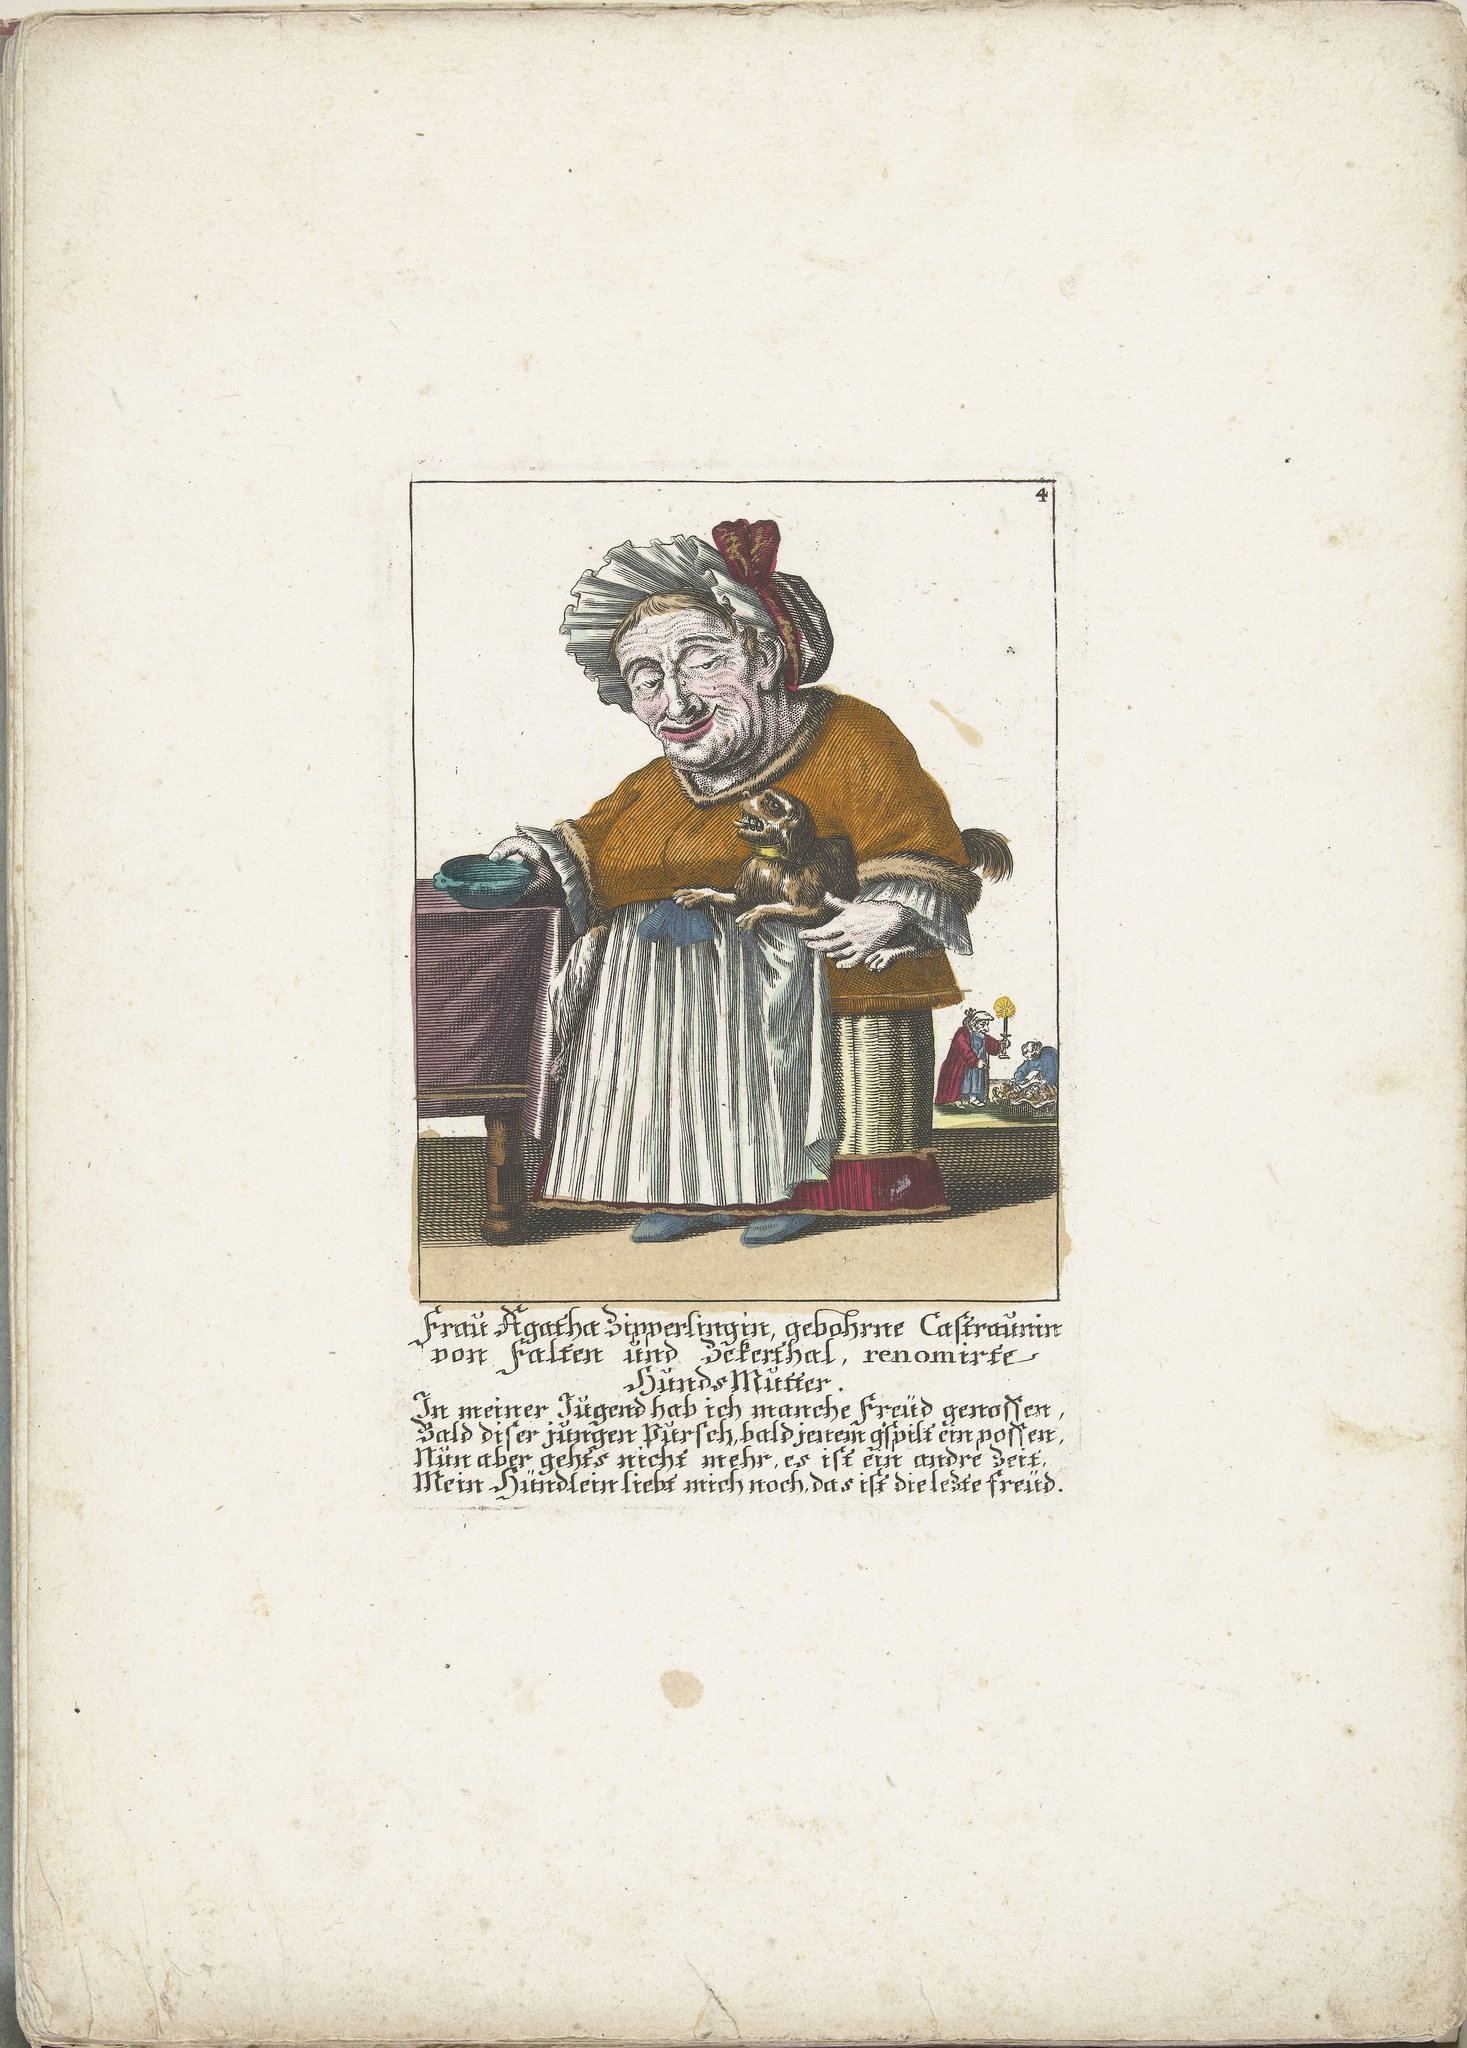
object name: caricature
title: Frau Agatha Zipperlingin, gebohrene Castaunin von Falten und Zeckerthal, renomirte Hundsmutter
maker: martin engelbrecht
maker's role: print maker, publisher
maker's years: 1684-1756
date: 1705-1715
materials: paper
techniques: engraving, etching, hand coloring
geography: augsburg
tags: caricatures (human types), little people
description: De kleine mens Frau Agatha Zipperlingin als een oude vrouw met een hondje op de arm. In het onderschrift onder de titel een vierregelig vers in het Duits. Genummerd rechtsboven: 4. Onderdeel van een losbladige uitgave uit ca. 1710 van een serie karikaturen van kleine mensen, bekend als Het Dwergentooneel.